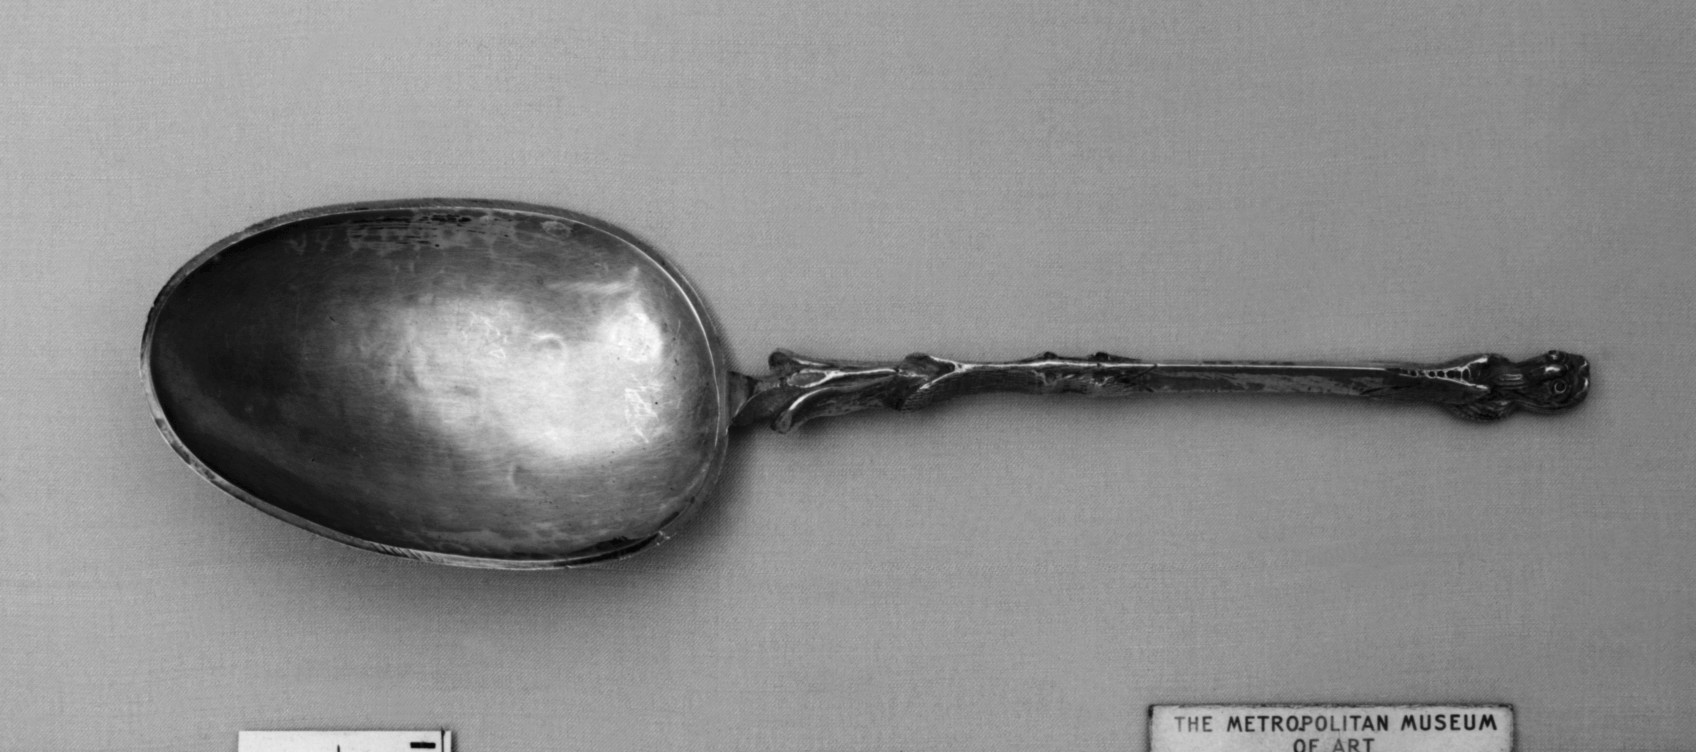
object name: spoon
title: Owl head spoon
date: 1708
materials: silver